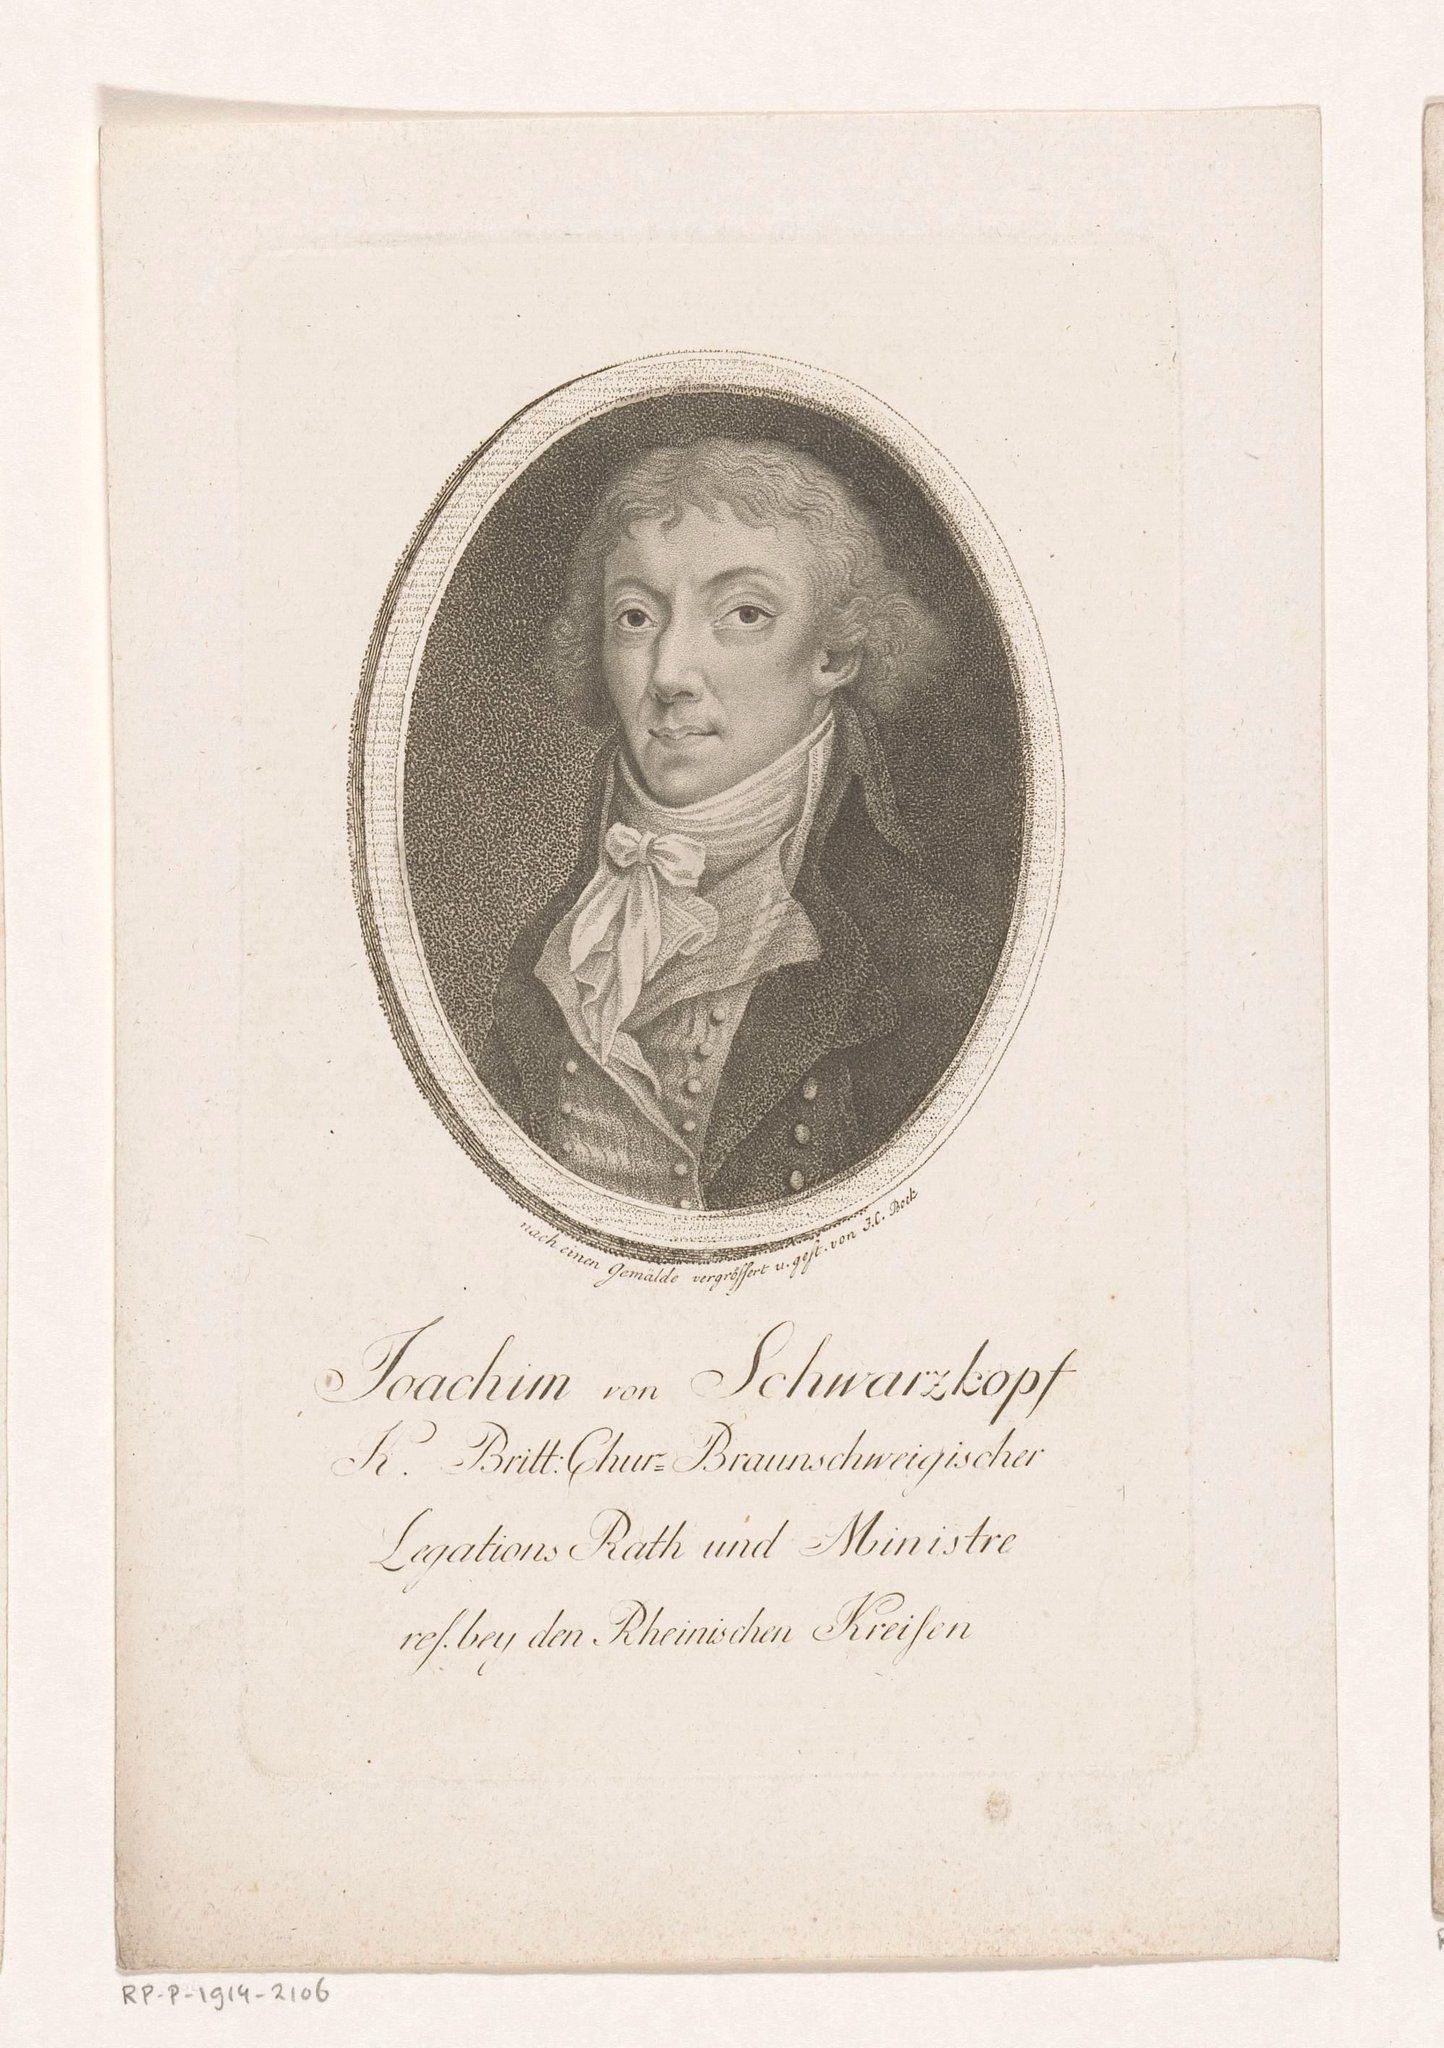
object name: print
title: Portret van Joachim Schwarzkopf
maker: johann carl bock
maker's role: print maker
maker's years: 1757-1843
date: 1805-1843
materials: paper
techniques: etching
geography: nuremberg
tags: historical persons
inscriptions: collector's mark: Lugt 2228